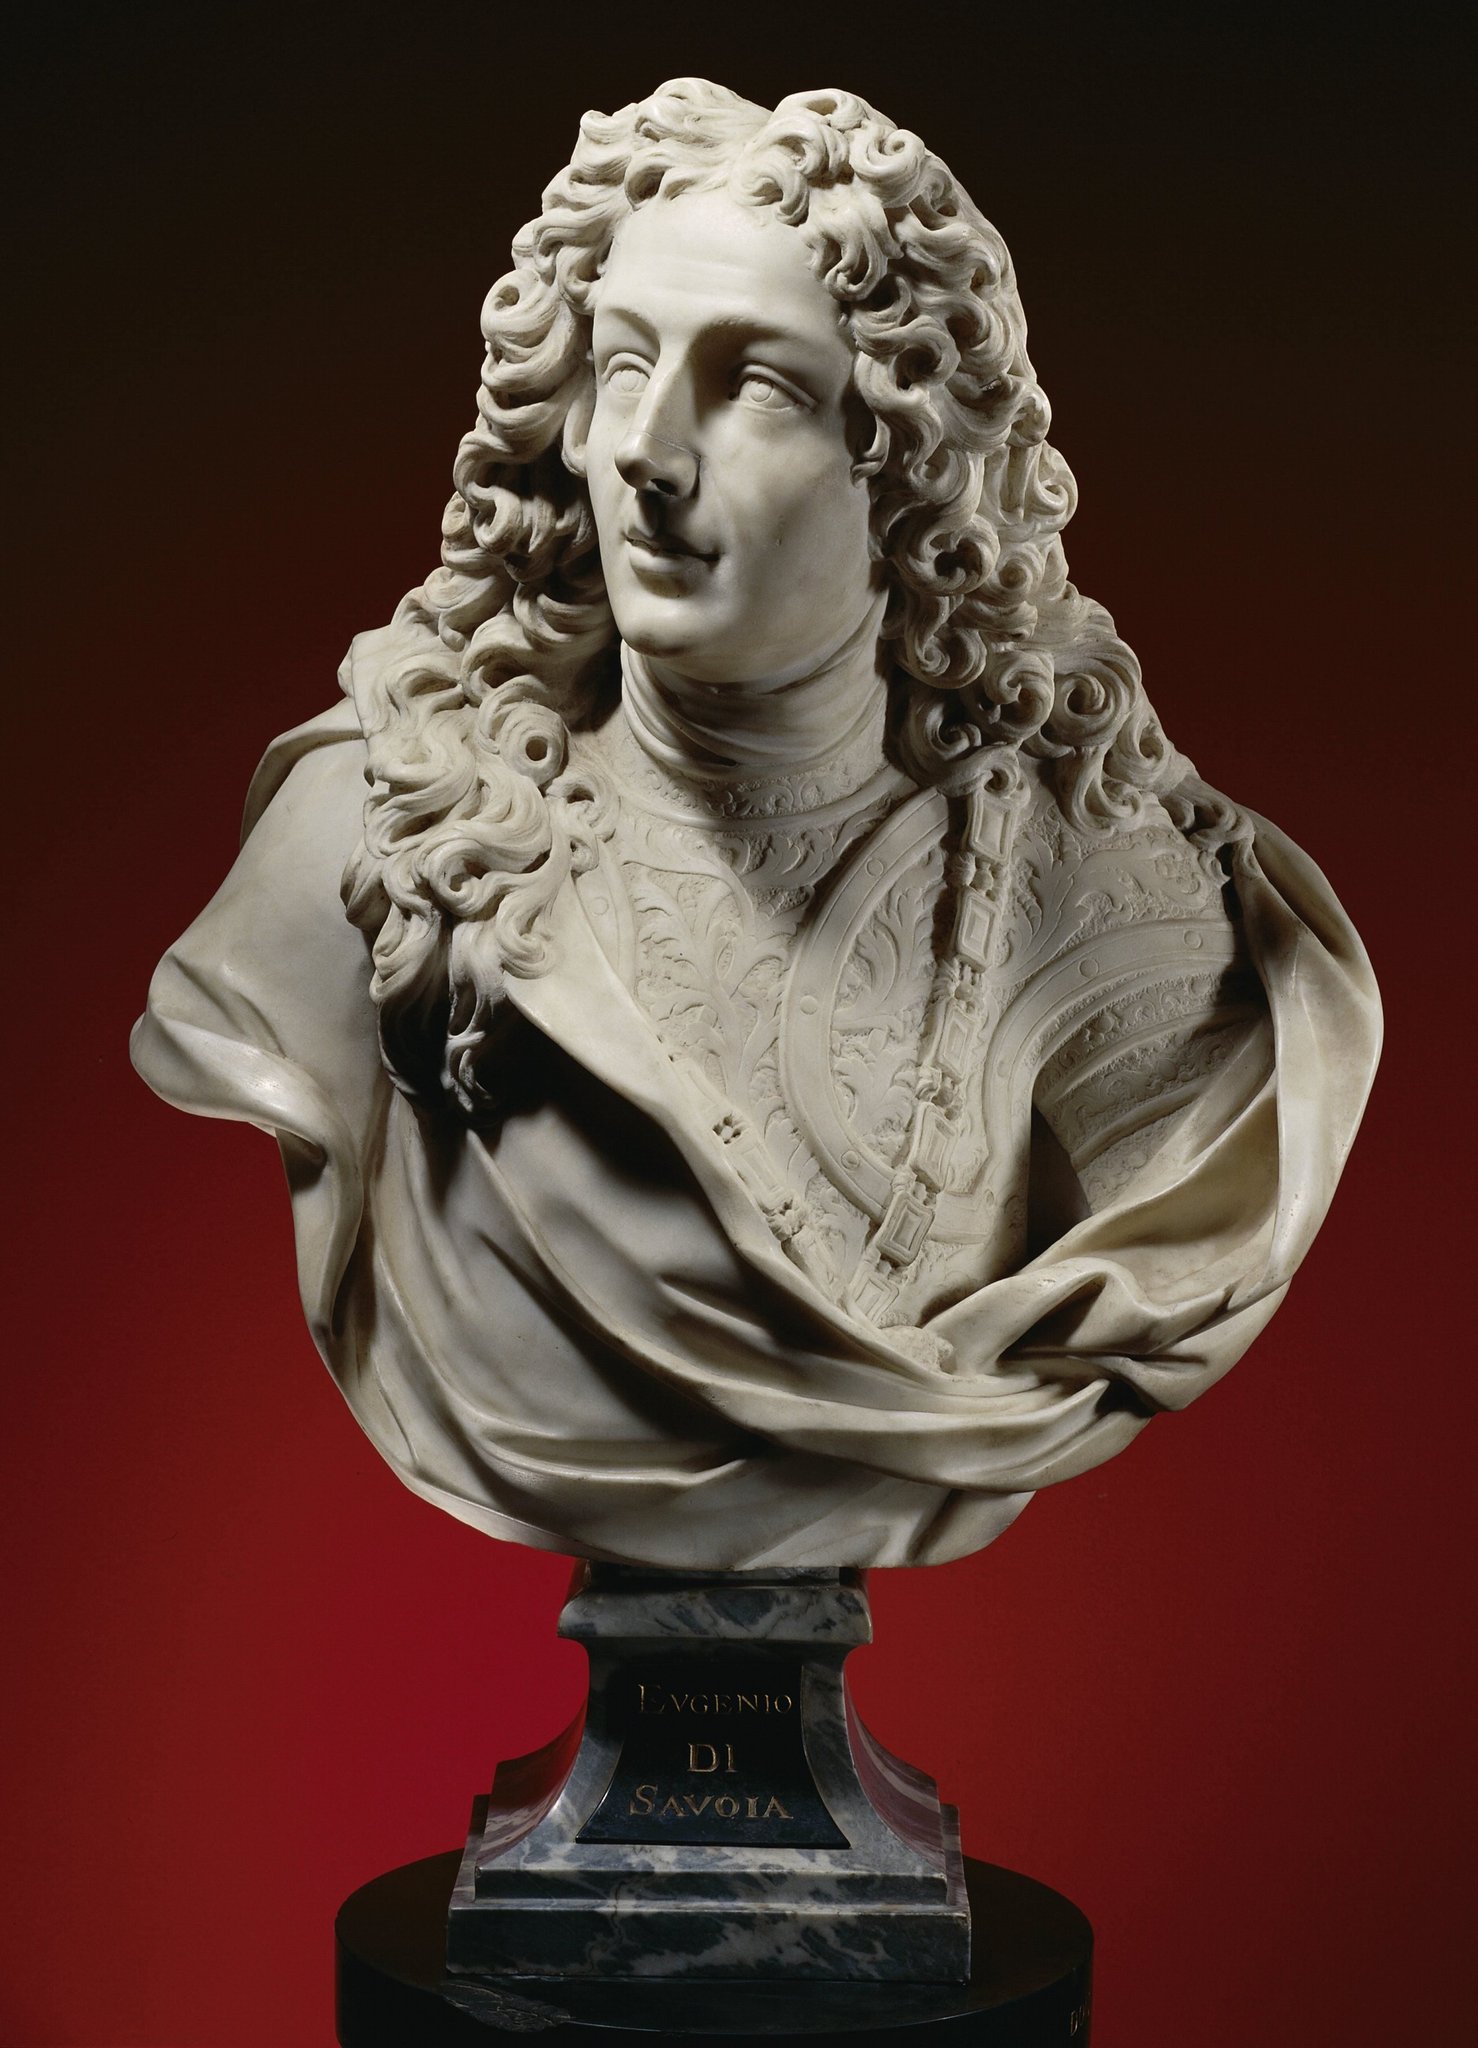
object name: bust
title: Bust of Prince Eugene of Savoy (1663-1736)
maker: francois coudray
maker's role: sculptor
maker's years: 1678-1727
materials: marble, wood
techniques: cutting, painted, carved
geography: dresden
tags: eugenius van savoye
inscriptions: inscription, on the marble socle, incised and gilded: ‘EVGENIO DI SAVOIA’, on the front side of the stone disc on top of the fluted column, incised: ‘EVGENIO DI SAVOIA DONATIVO DEL PRINCIPE A G: CLIFFORD A° MDCCXXIV’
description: Eugene of Savoy, attributed to François Coudray, 1724. The Austrian general Prince Eugene of Savoy (1663-1736) was one of the commanders of the anti-French alliance of the War of the Spanish Succession (1701-1714). In 1716 he was appointed viceroy of the Austrian (Southern) Netherlands. Eugene is portrayed here as a general dressed in a richly decorated state cuirass. About his neck is the insignia of the Order of the Golden Fleece. Eugene gave the bust to the Amsterdam banker George Clifford who had helped facilitate the princes many art purchases in Amsterdam.